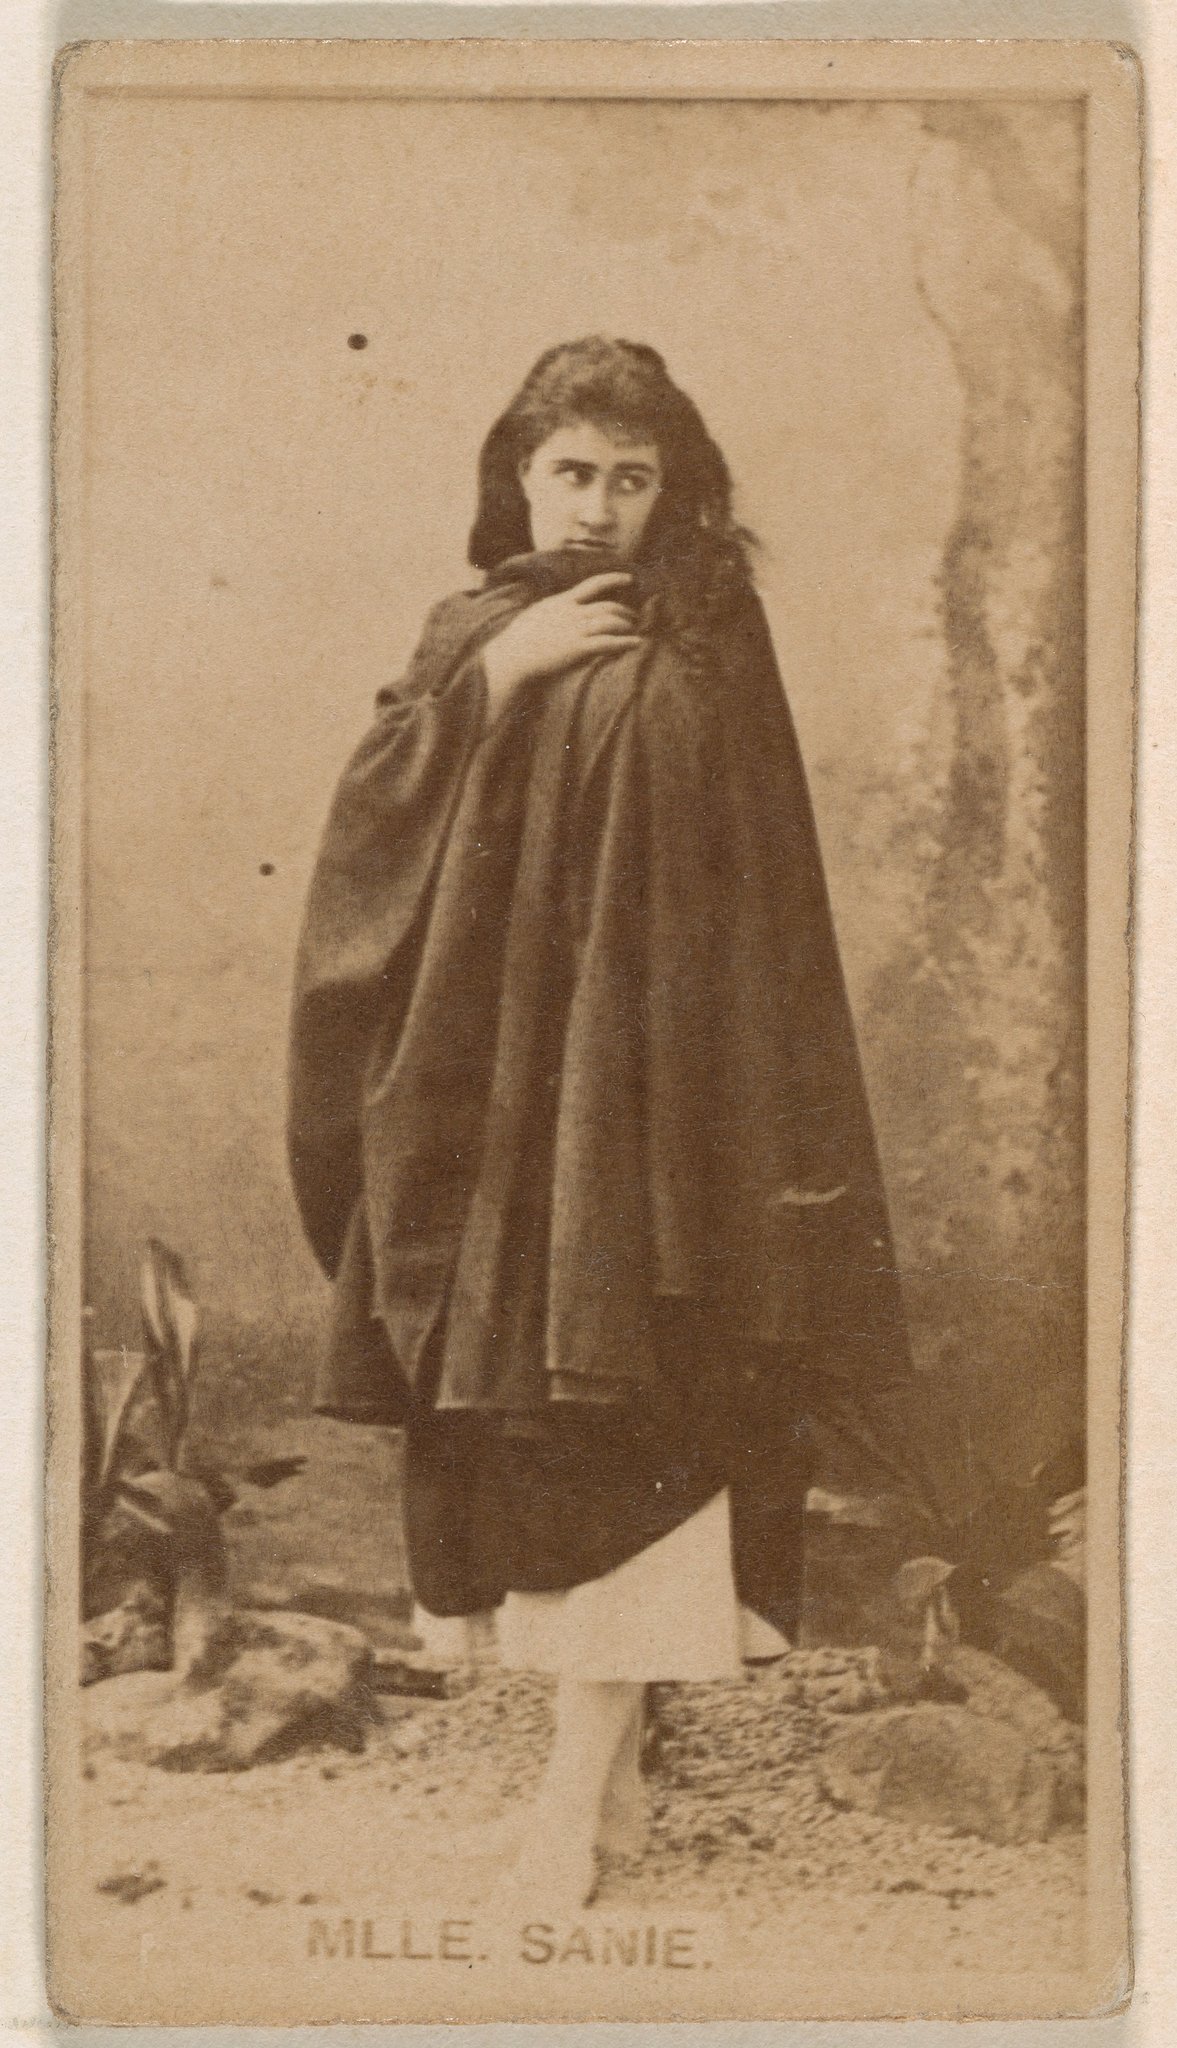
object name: photograph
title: Mlle. Sanie, from the Actresses series (N245) issued by Kinney Brothers to promote Sweet Caporal Cigarettes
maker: kinney brothers tobacco company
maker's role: publisher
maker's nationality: american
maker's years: 1869-2011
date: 1890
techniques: albumen silver print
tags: portraits,women,actresses